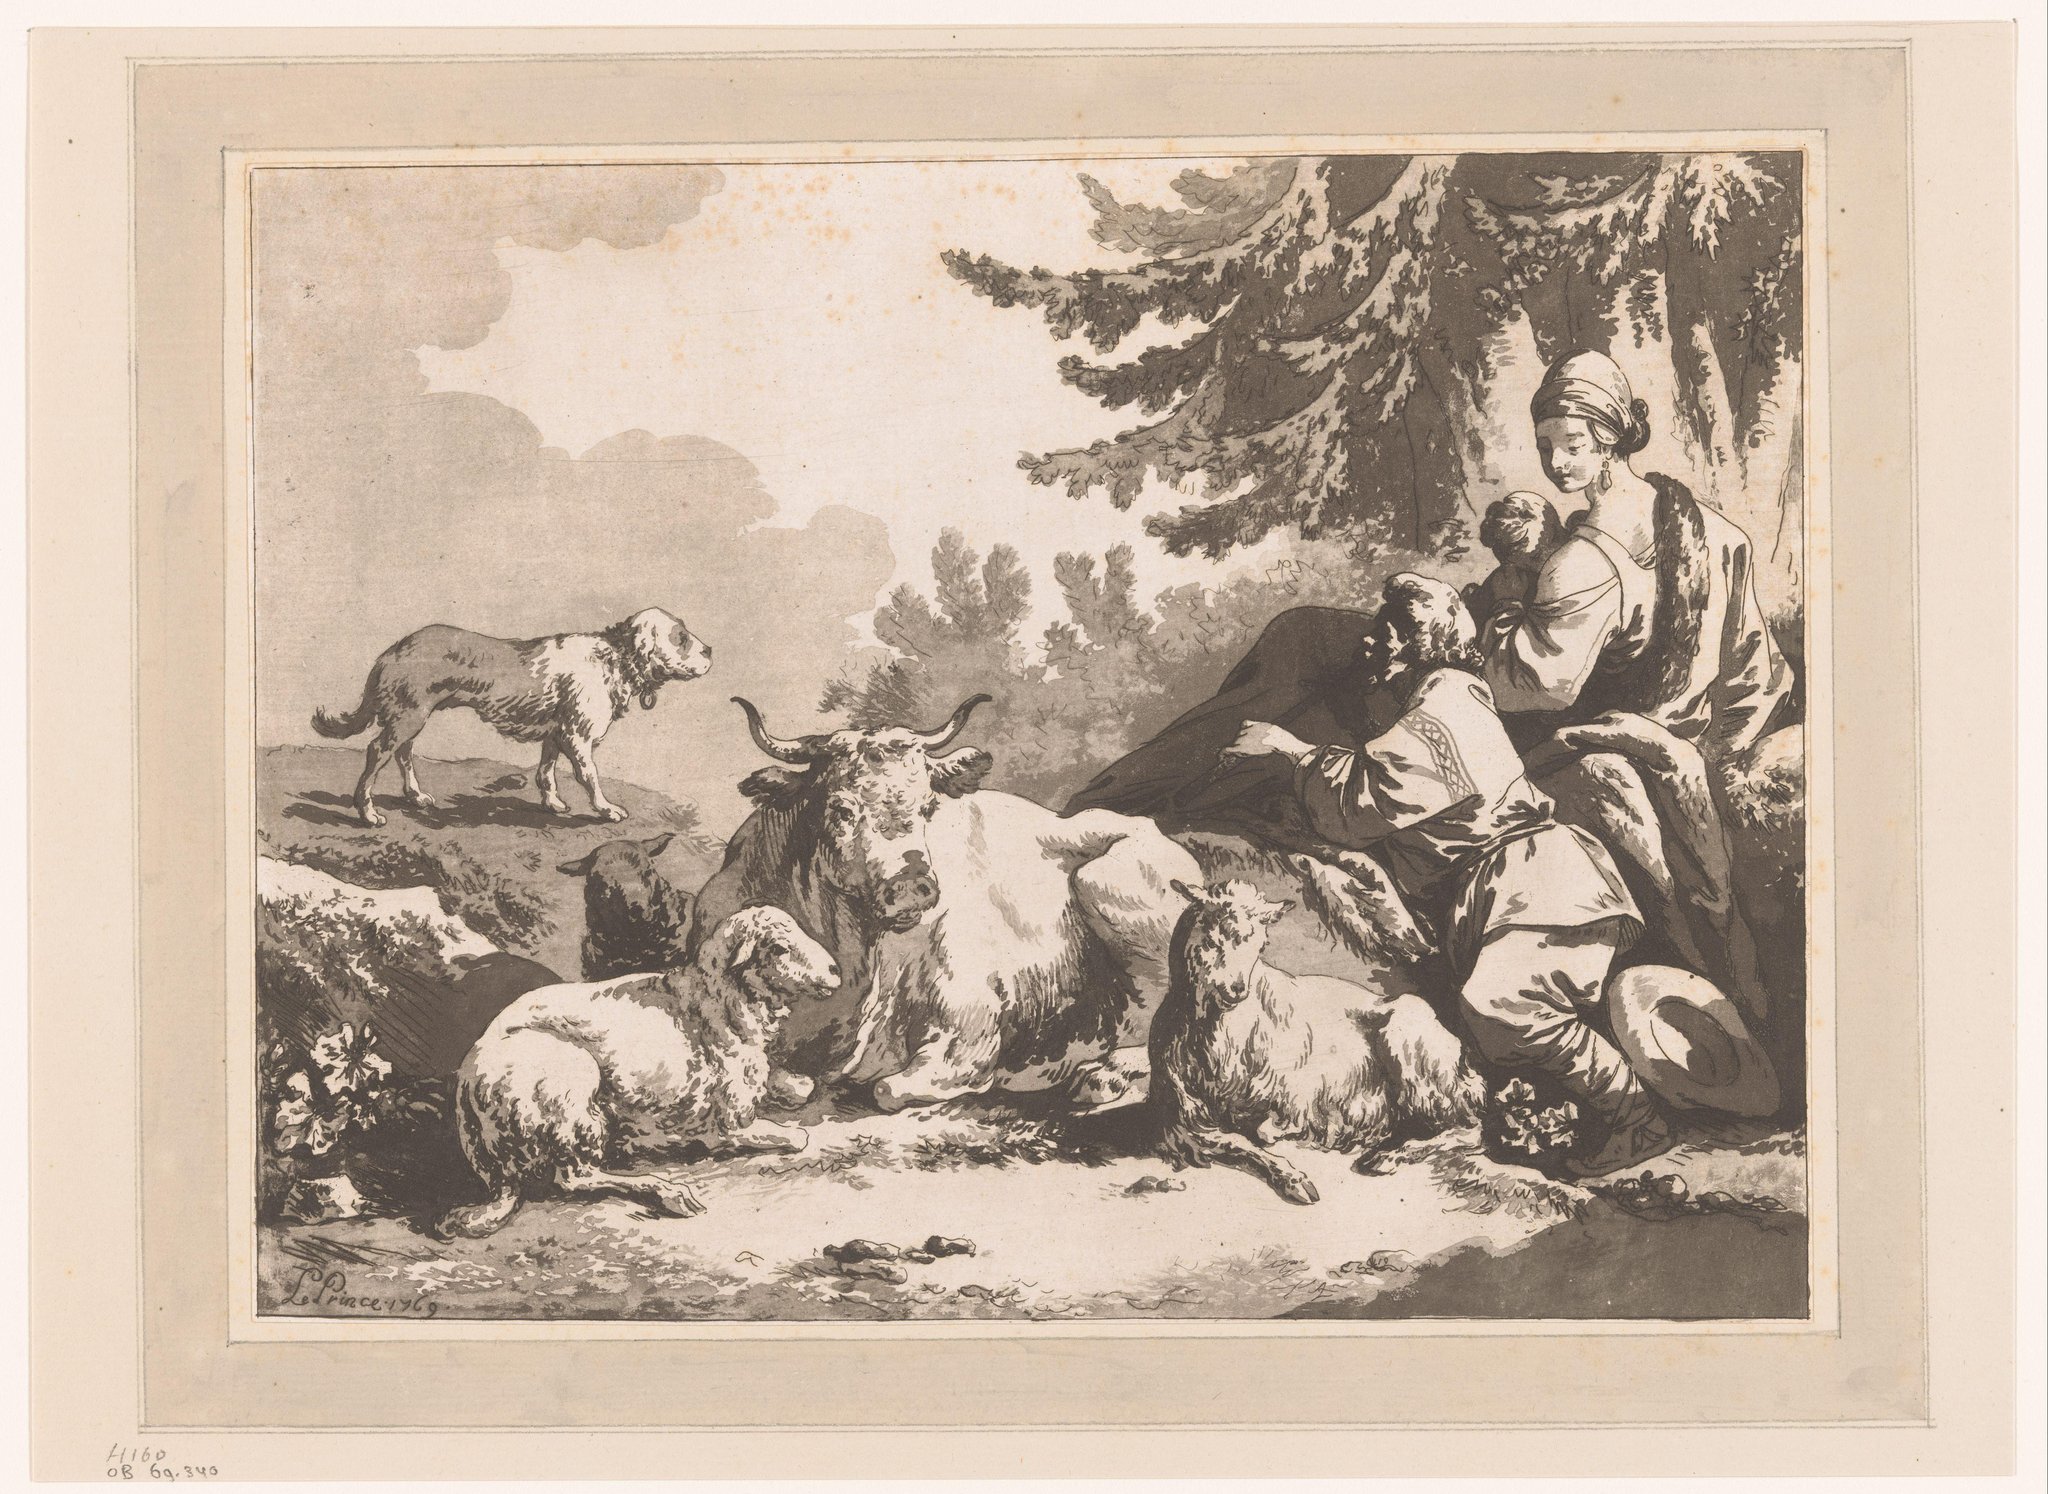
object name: print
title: Rustende herders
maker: jean baptist leprince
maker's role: draughtsman, print maker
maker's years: 1734-1781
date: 1769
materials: paper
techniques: aquatint, etching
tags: cow, herding, herdsman, herdswoman, shepherd, shepherdess, cowherd, etc., sheep, resting - bb - out of doors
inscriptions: collector's mark: Lugt 2228